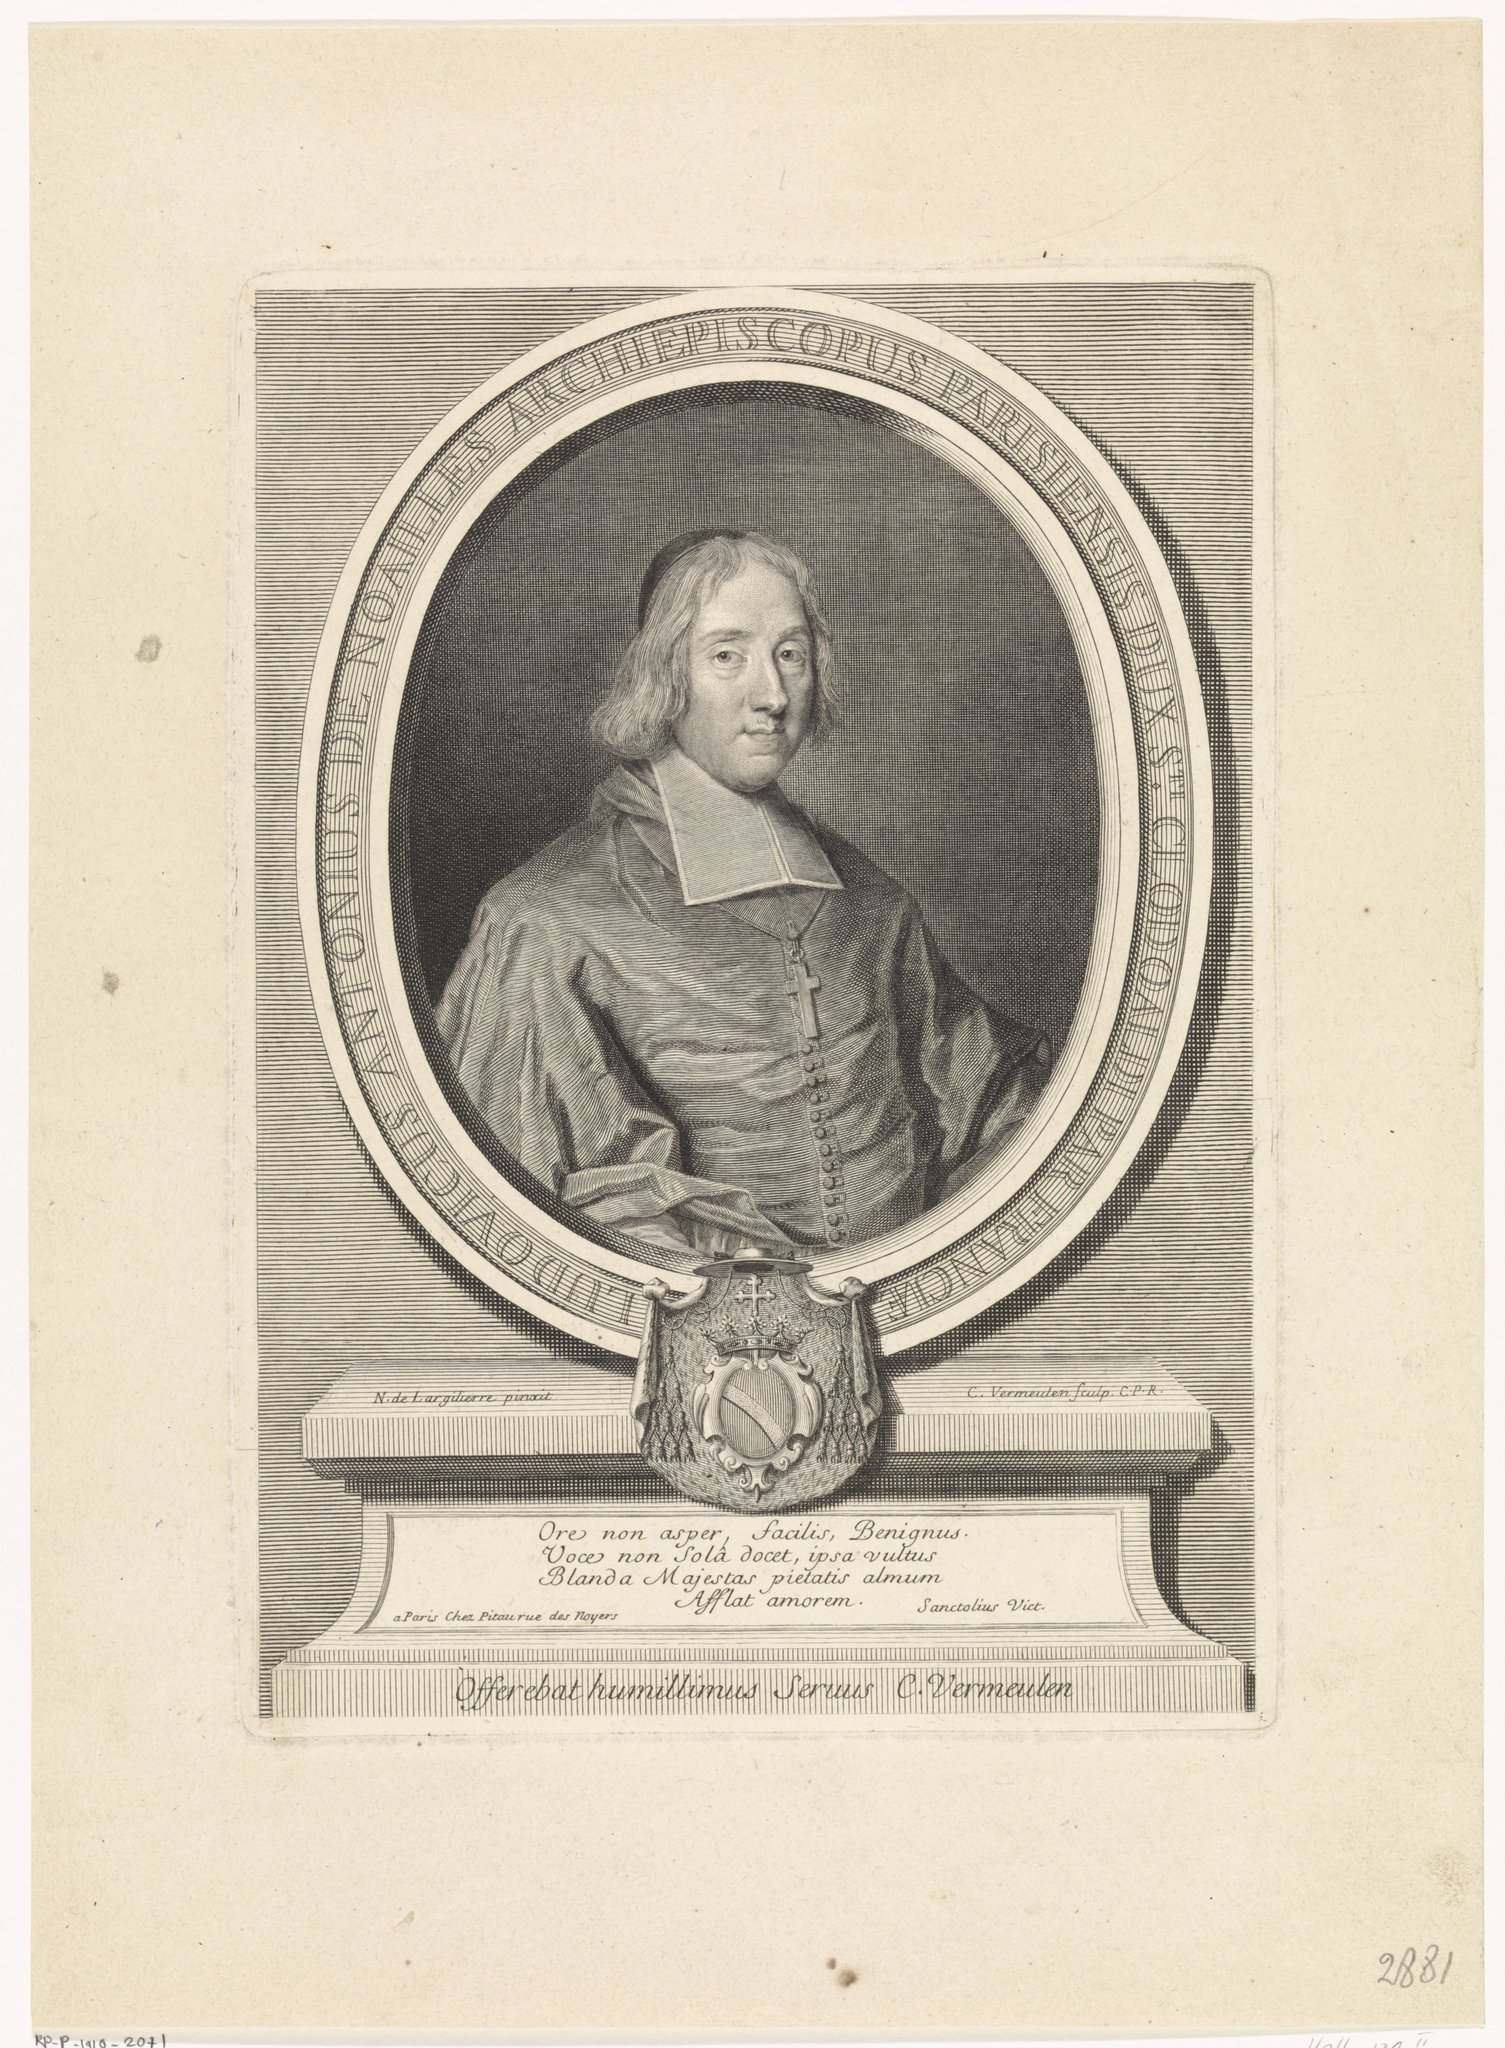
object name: print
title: Portret van Louis-Antoine de Noailles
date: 1695-1702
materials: paper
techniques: engraving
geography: paris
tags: paris, priest, louis-antoine de noailles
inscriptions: collector's mark: Lugt 2228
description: Portret van Louis-Antoine de Noailles, aartsbisschop van Parijs.